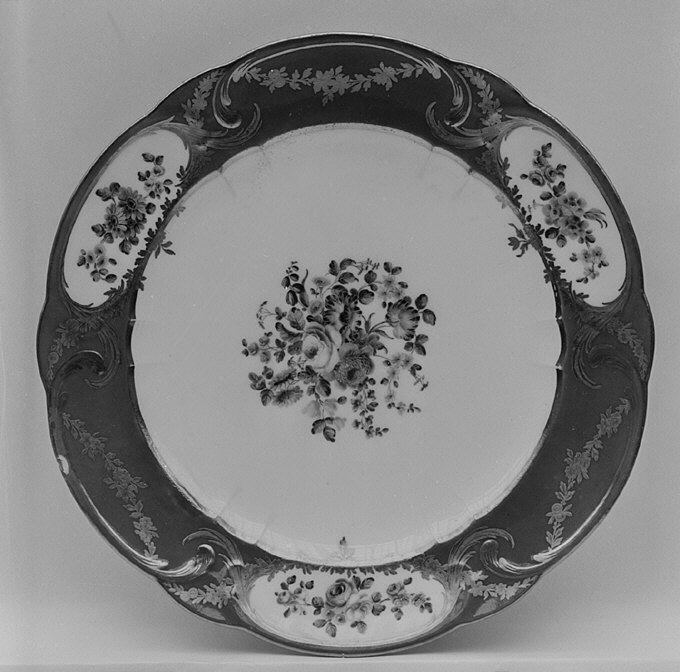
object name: plate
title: Plate (Assiette à palmes) (1 of 102) (part of a service)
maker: sèvres manufactory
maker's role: manufactory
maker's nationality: french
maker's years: 1740-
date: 1772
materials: soft paste porcelain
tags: flowers